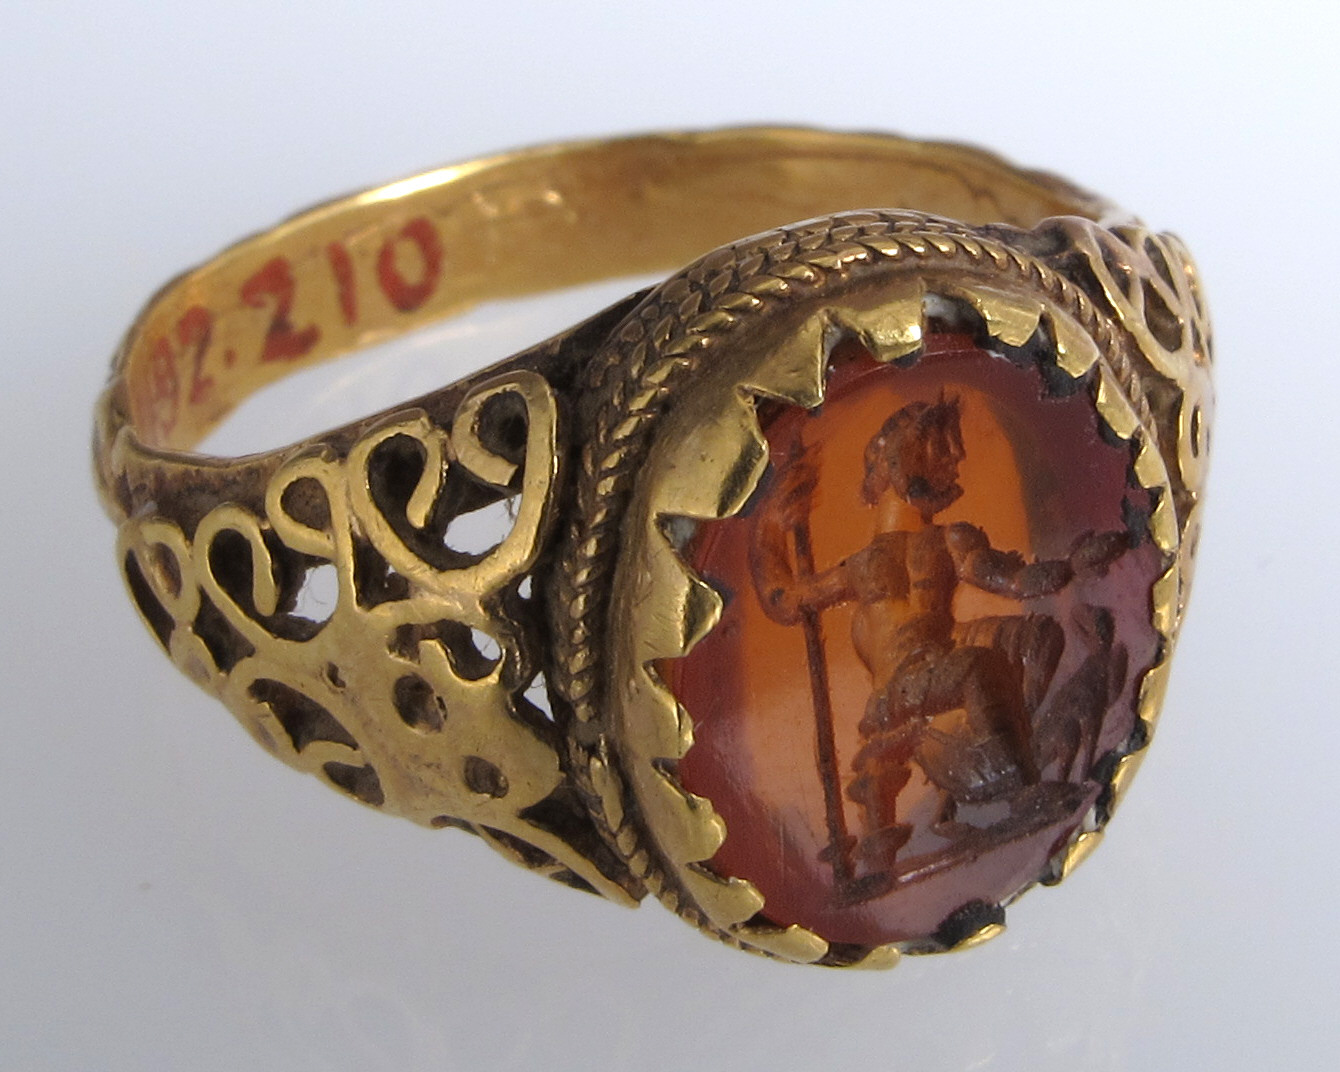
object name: ring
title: Finger Ring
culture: east germanic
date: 201-300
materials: gemstone, gold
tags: men